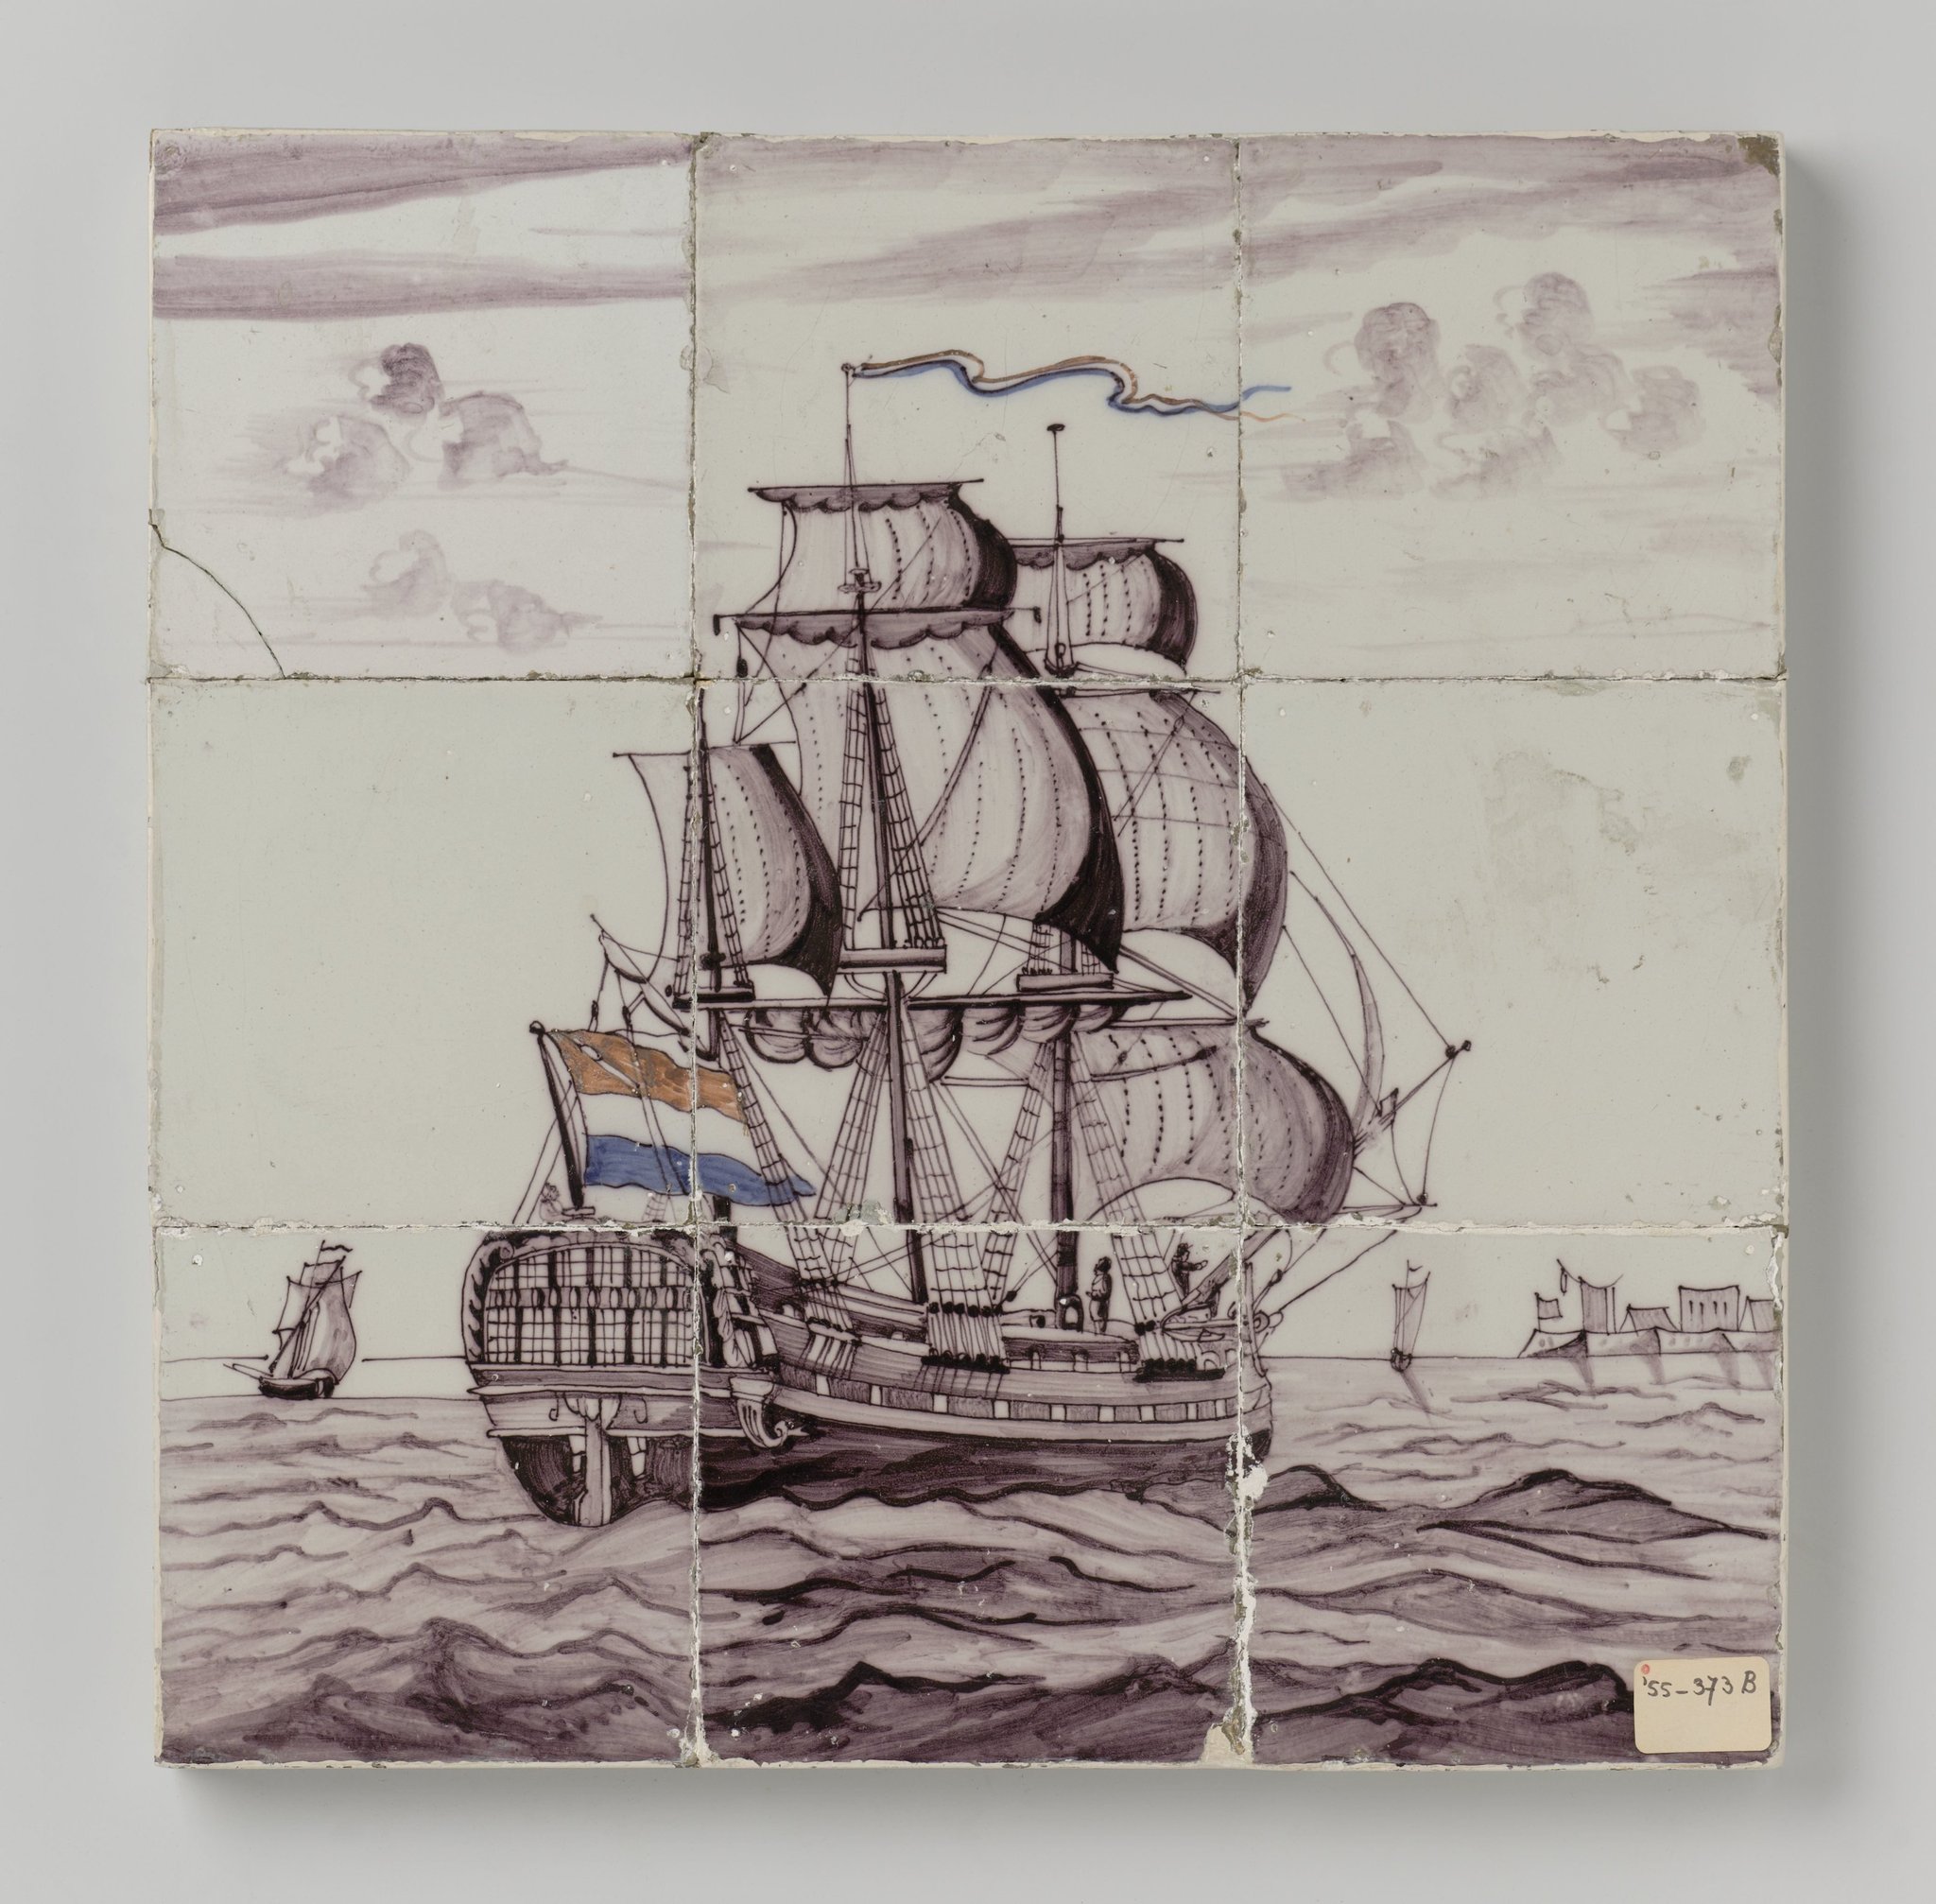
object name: tile tableau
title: Tegeltableau met driemaster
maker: Anonymous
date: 1780-1820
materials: earthenware, glaze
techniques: maiolica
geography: netherlands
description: Tegeltableau van negen tegels (3 x 3) met een paars geschilderde driemaster met de Nederlandse vlag. Rechts op de achtergrond, een stadsgezicht en links een zeilschip.